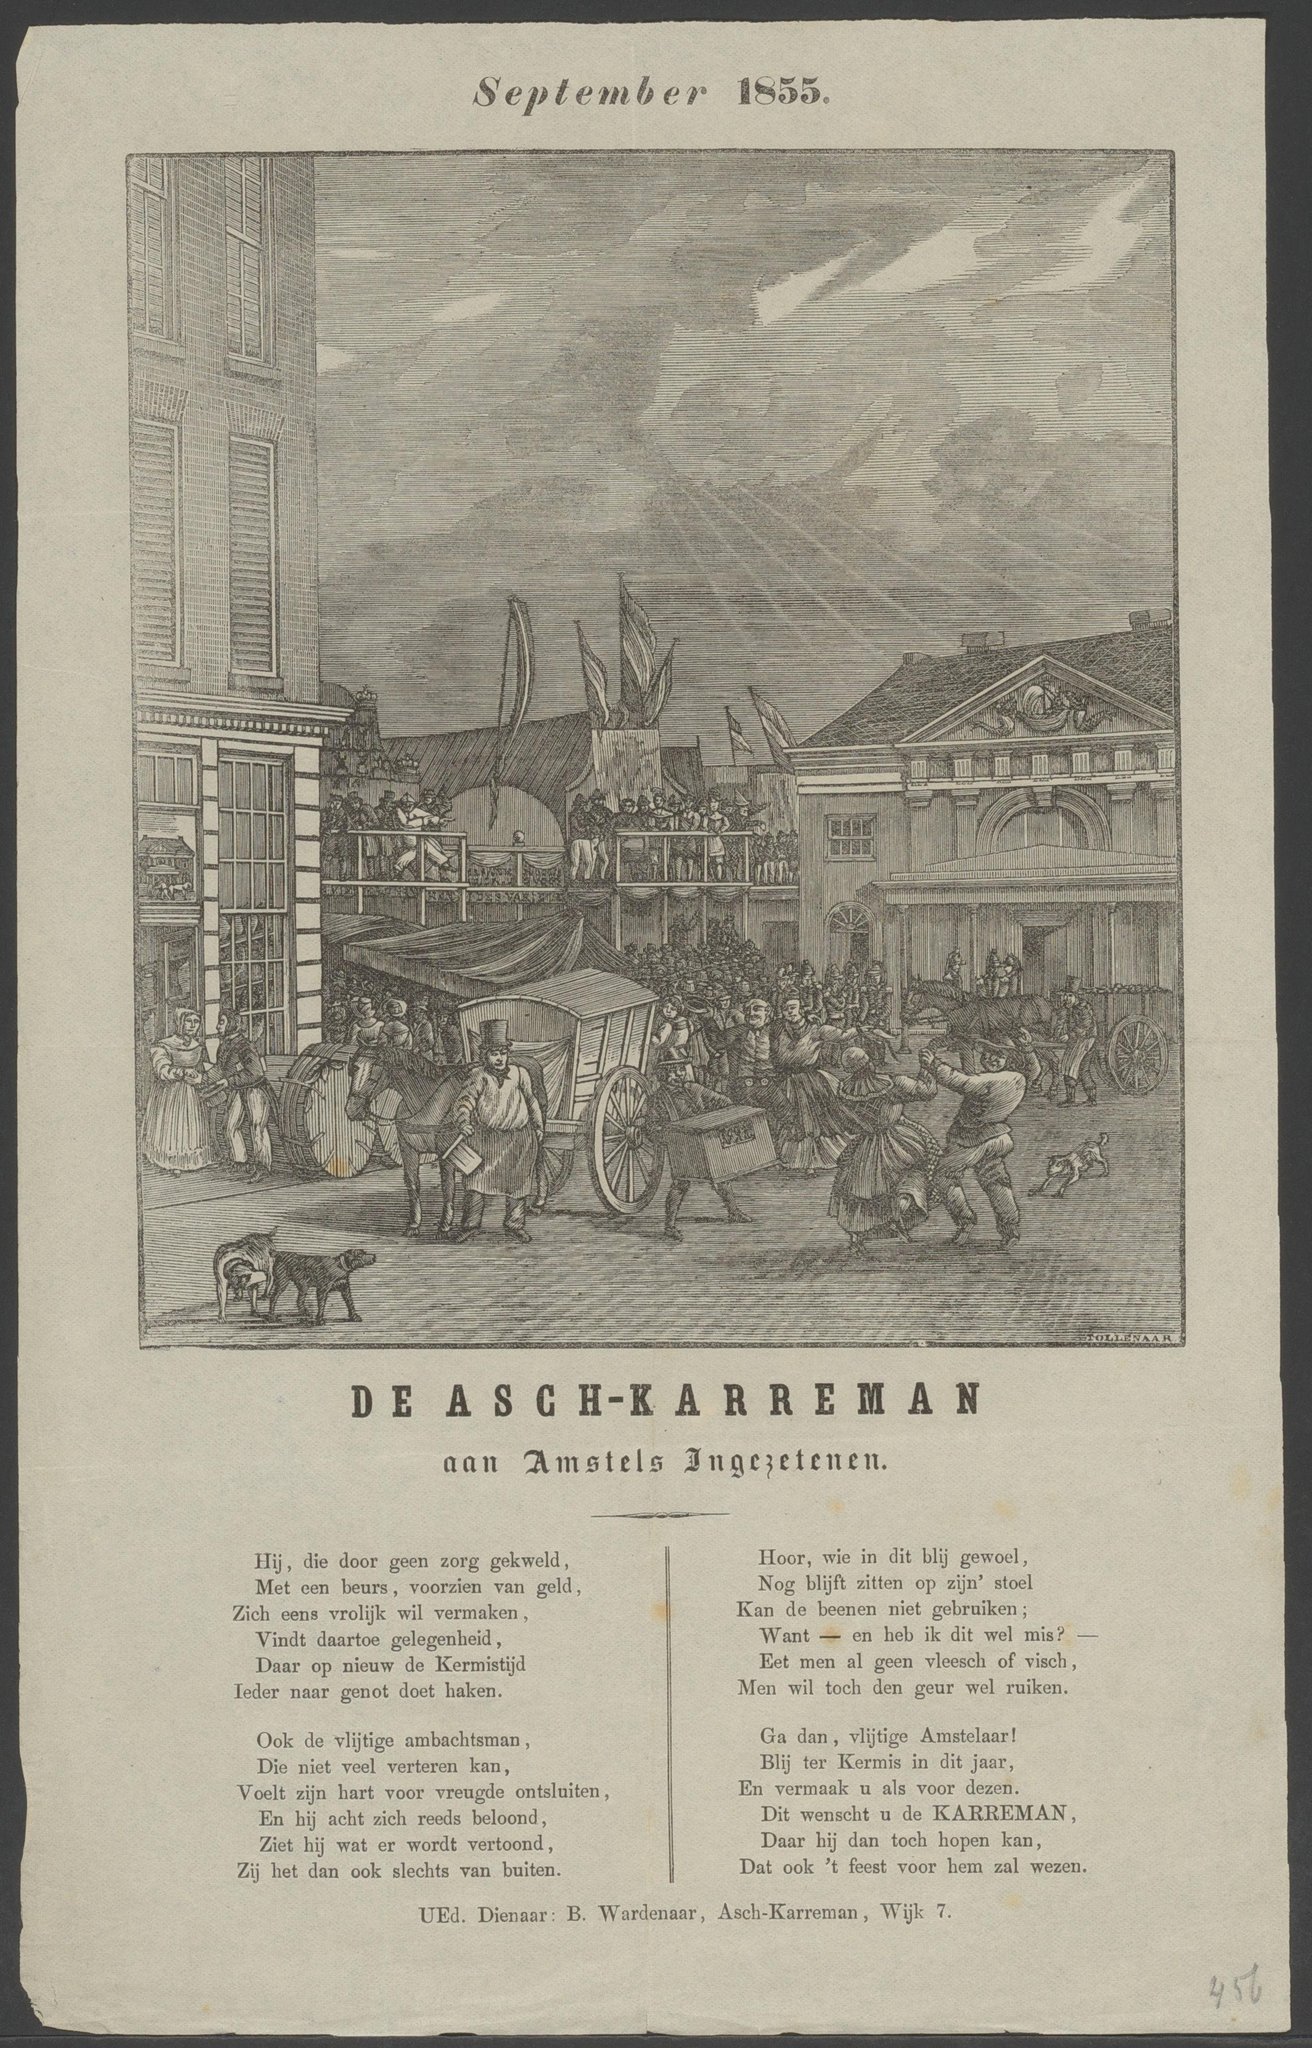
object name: fair print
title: Kermisprent van de Amsterdamse askarrenmannen voor het jaar 1855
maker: dirk wijbrand tollenaar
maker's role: print maker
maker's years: 1808-1858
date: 1855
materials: paper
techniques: letterpress printing, engraving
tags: pleasure fair and circus, garbage collection, amsterdam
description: Kermisprent namens de askarrenmannen (karrenman of vuilnisman) te Amsterdam, september 1855. Gezicht op de kermis op de Botermarkt met de Regulierswaag. Op de markt twee vuilniskarren. Onderaan een gedicht in twee kolommen. Namens B. Wardenaar, de askarreman van wijk no. 7. Onderwerpsrubrieken binnen de Atlas Zeden en Gewoonten: Zeden en gewoonten in engeren zin, Volksleven, Volksbladen, Nieuwjaars- en Kerstwenschen, Amsterdam.